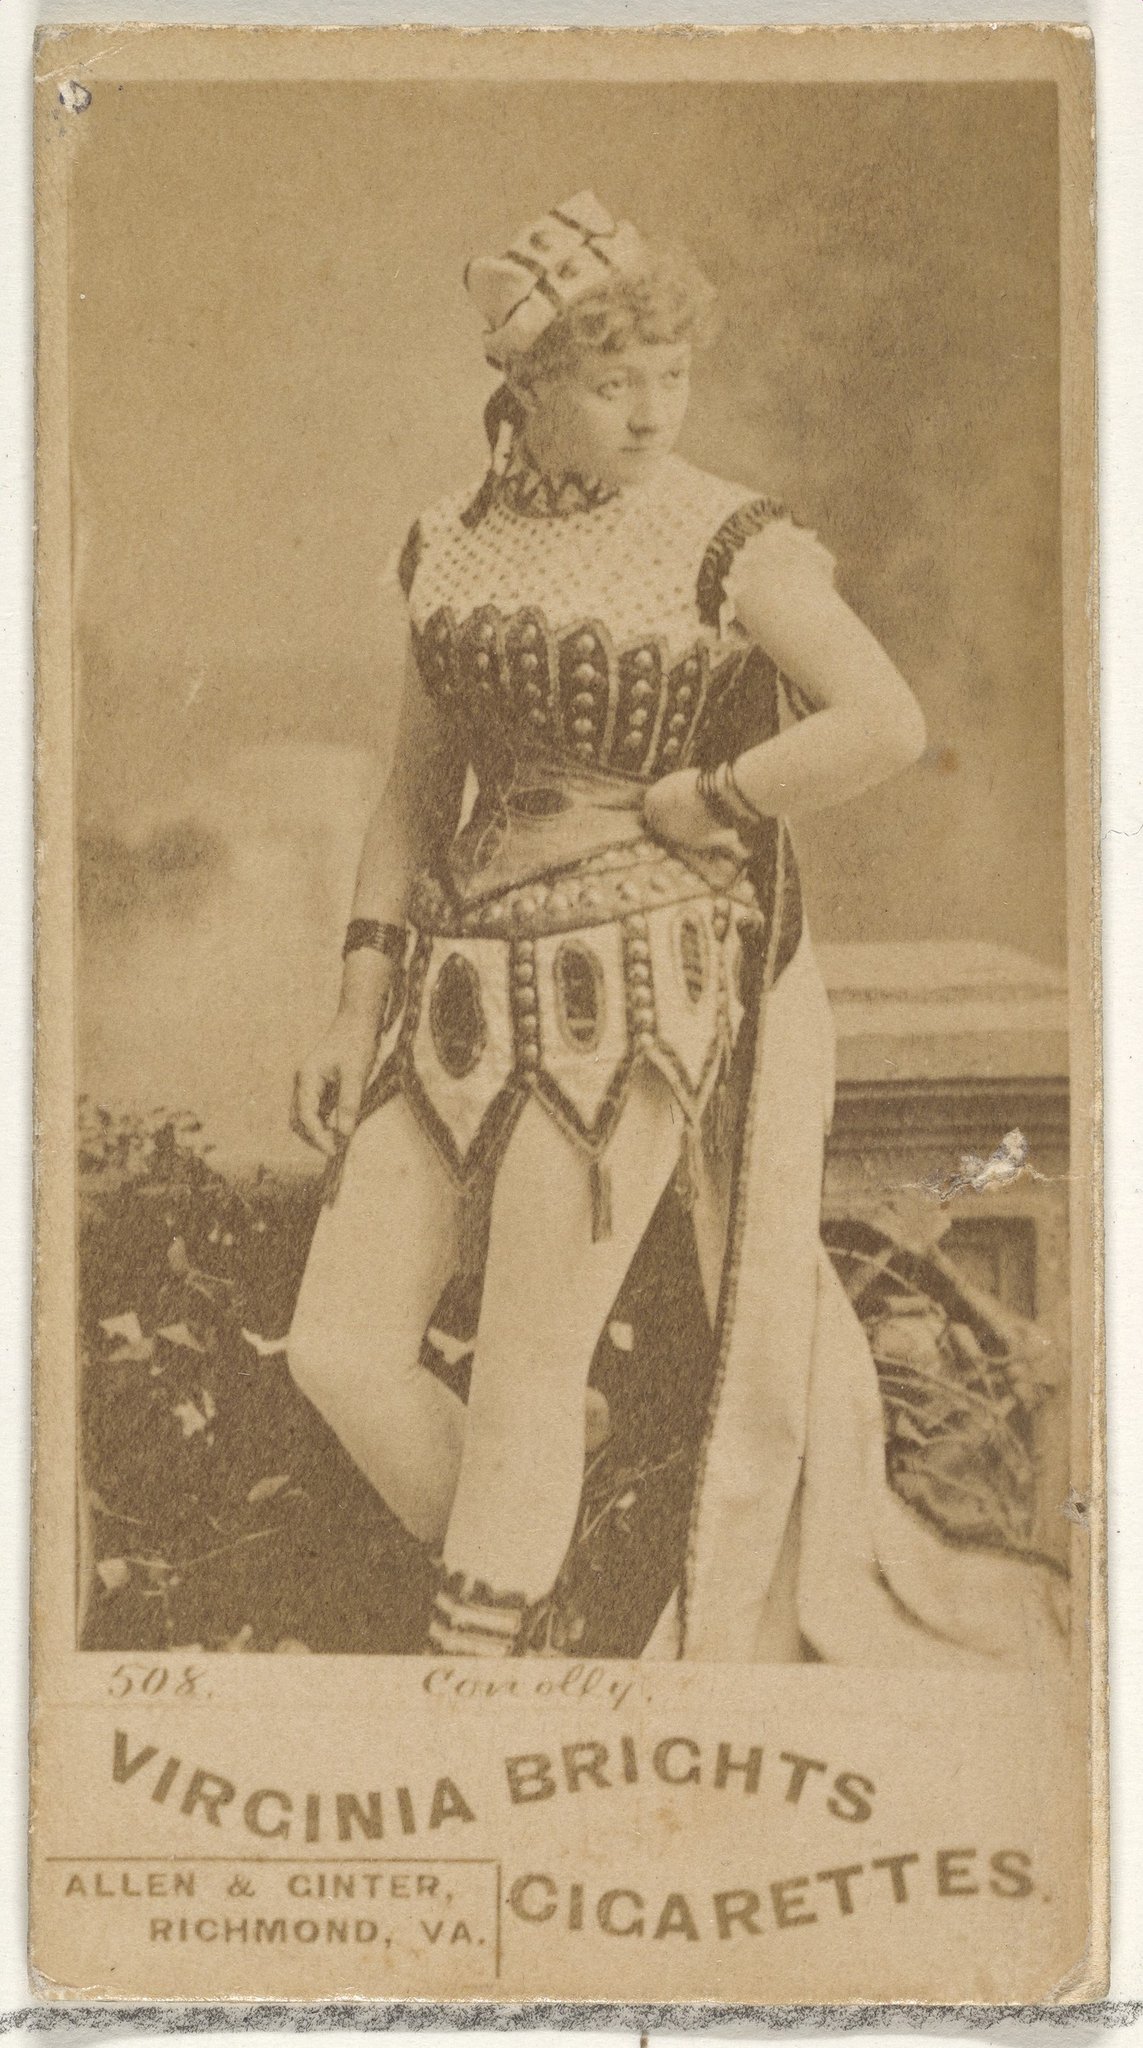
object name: photograph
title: Card 508, Conolly, from the Actors and Actresses series (N45, Type 1) for Virginia Brights Cigarettes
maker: allen & ginter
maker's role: publisher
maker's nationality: american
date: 1888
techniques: albumen silver print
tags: portraits,women,actresses